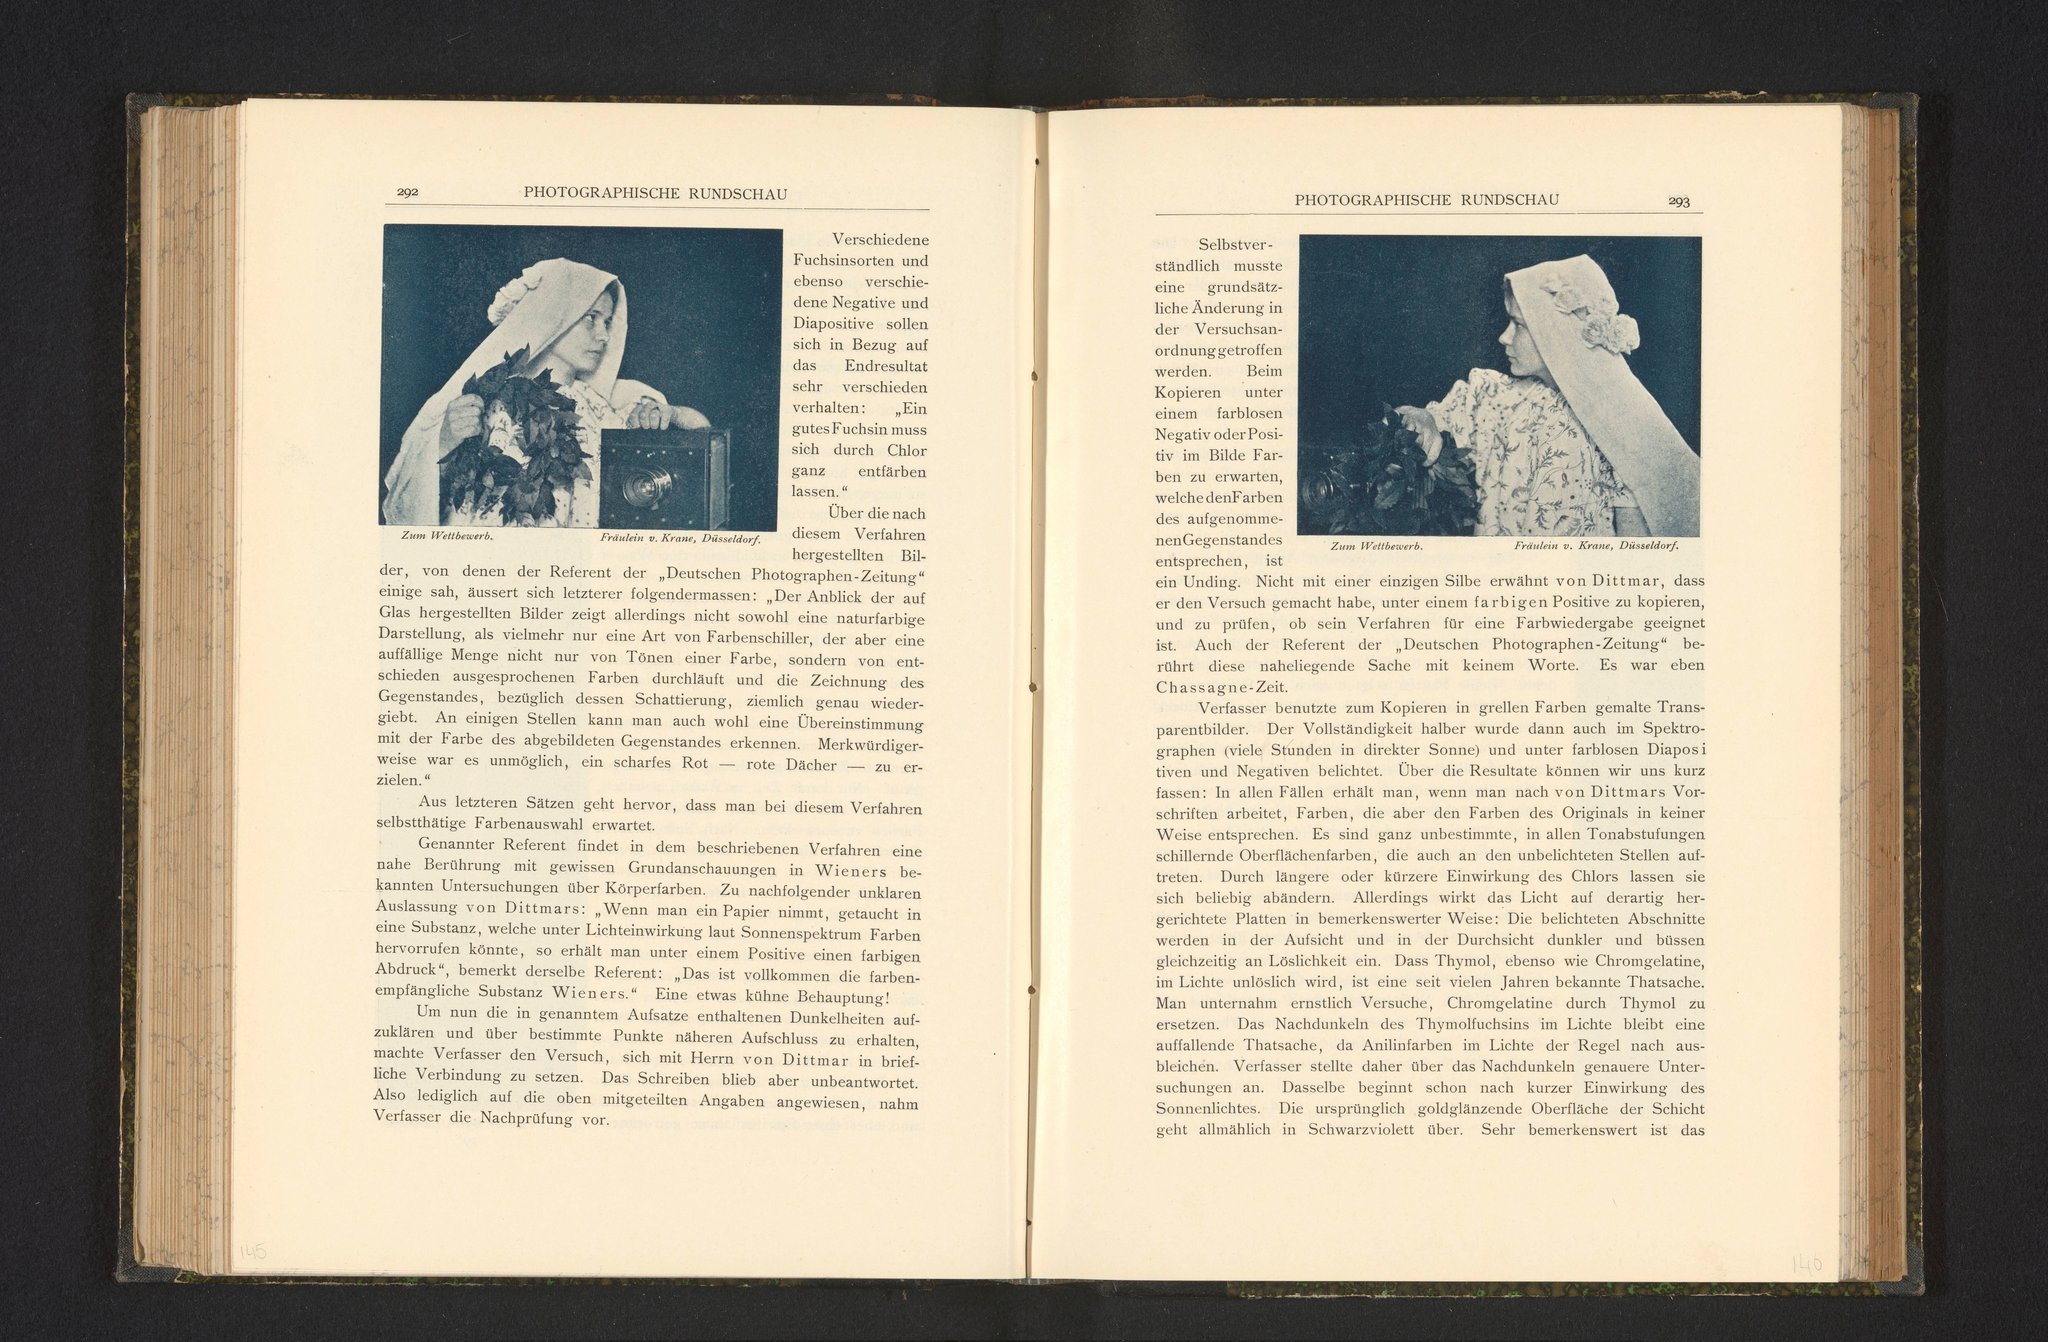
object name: page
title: Portret van een onbekende vrouw met bloemen en een camera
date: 1893-1898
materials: paper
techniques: autotype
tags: flowers, adult woman, camera ~ photography